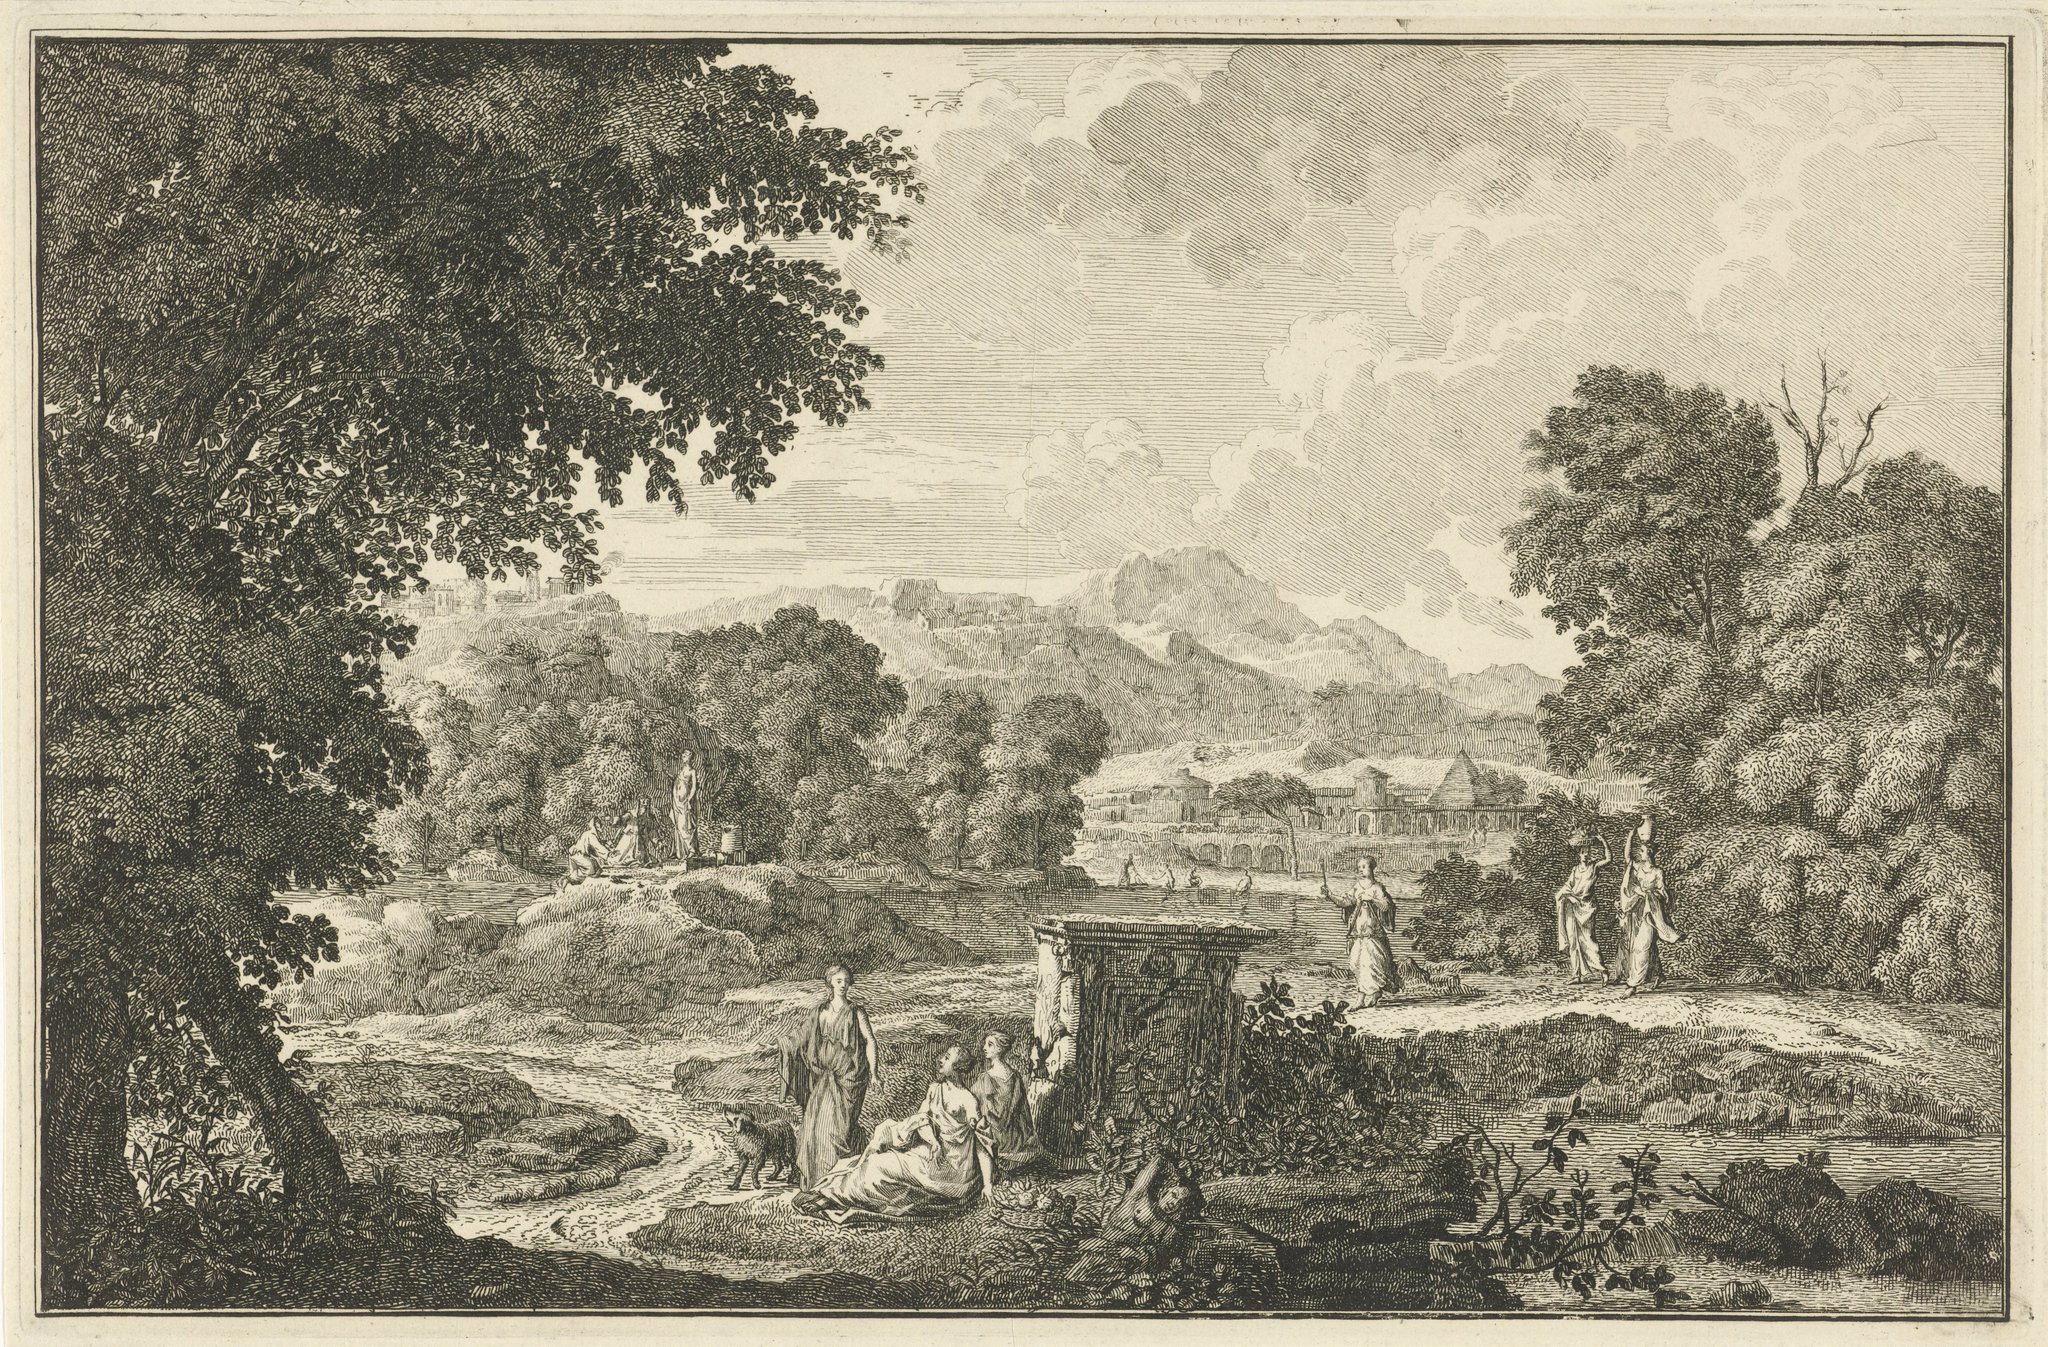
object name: print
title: Arcadisch landschap met zes vrouwen bij een tombe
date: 1710-1747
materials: paper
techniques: etching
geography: amsterdam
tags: landscapes with waters, waterscapes, seascapes (in the temperate zone), grave, tomb, statues, paintings, etc. ~ objects of worship in roman religion, dog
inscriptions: collector's mark: Lugt 240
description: Arcadisch landschap met zes vrouwen en een hond bij een tombe. Op de achtergrond zijn twee figuren voor een standbeeld geknield. De prent maakt deel uit van een 40-delige serie prenten met voorstellingen van Italiaanse en Duitse landschappen.